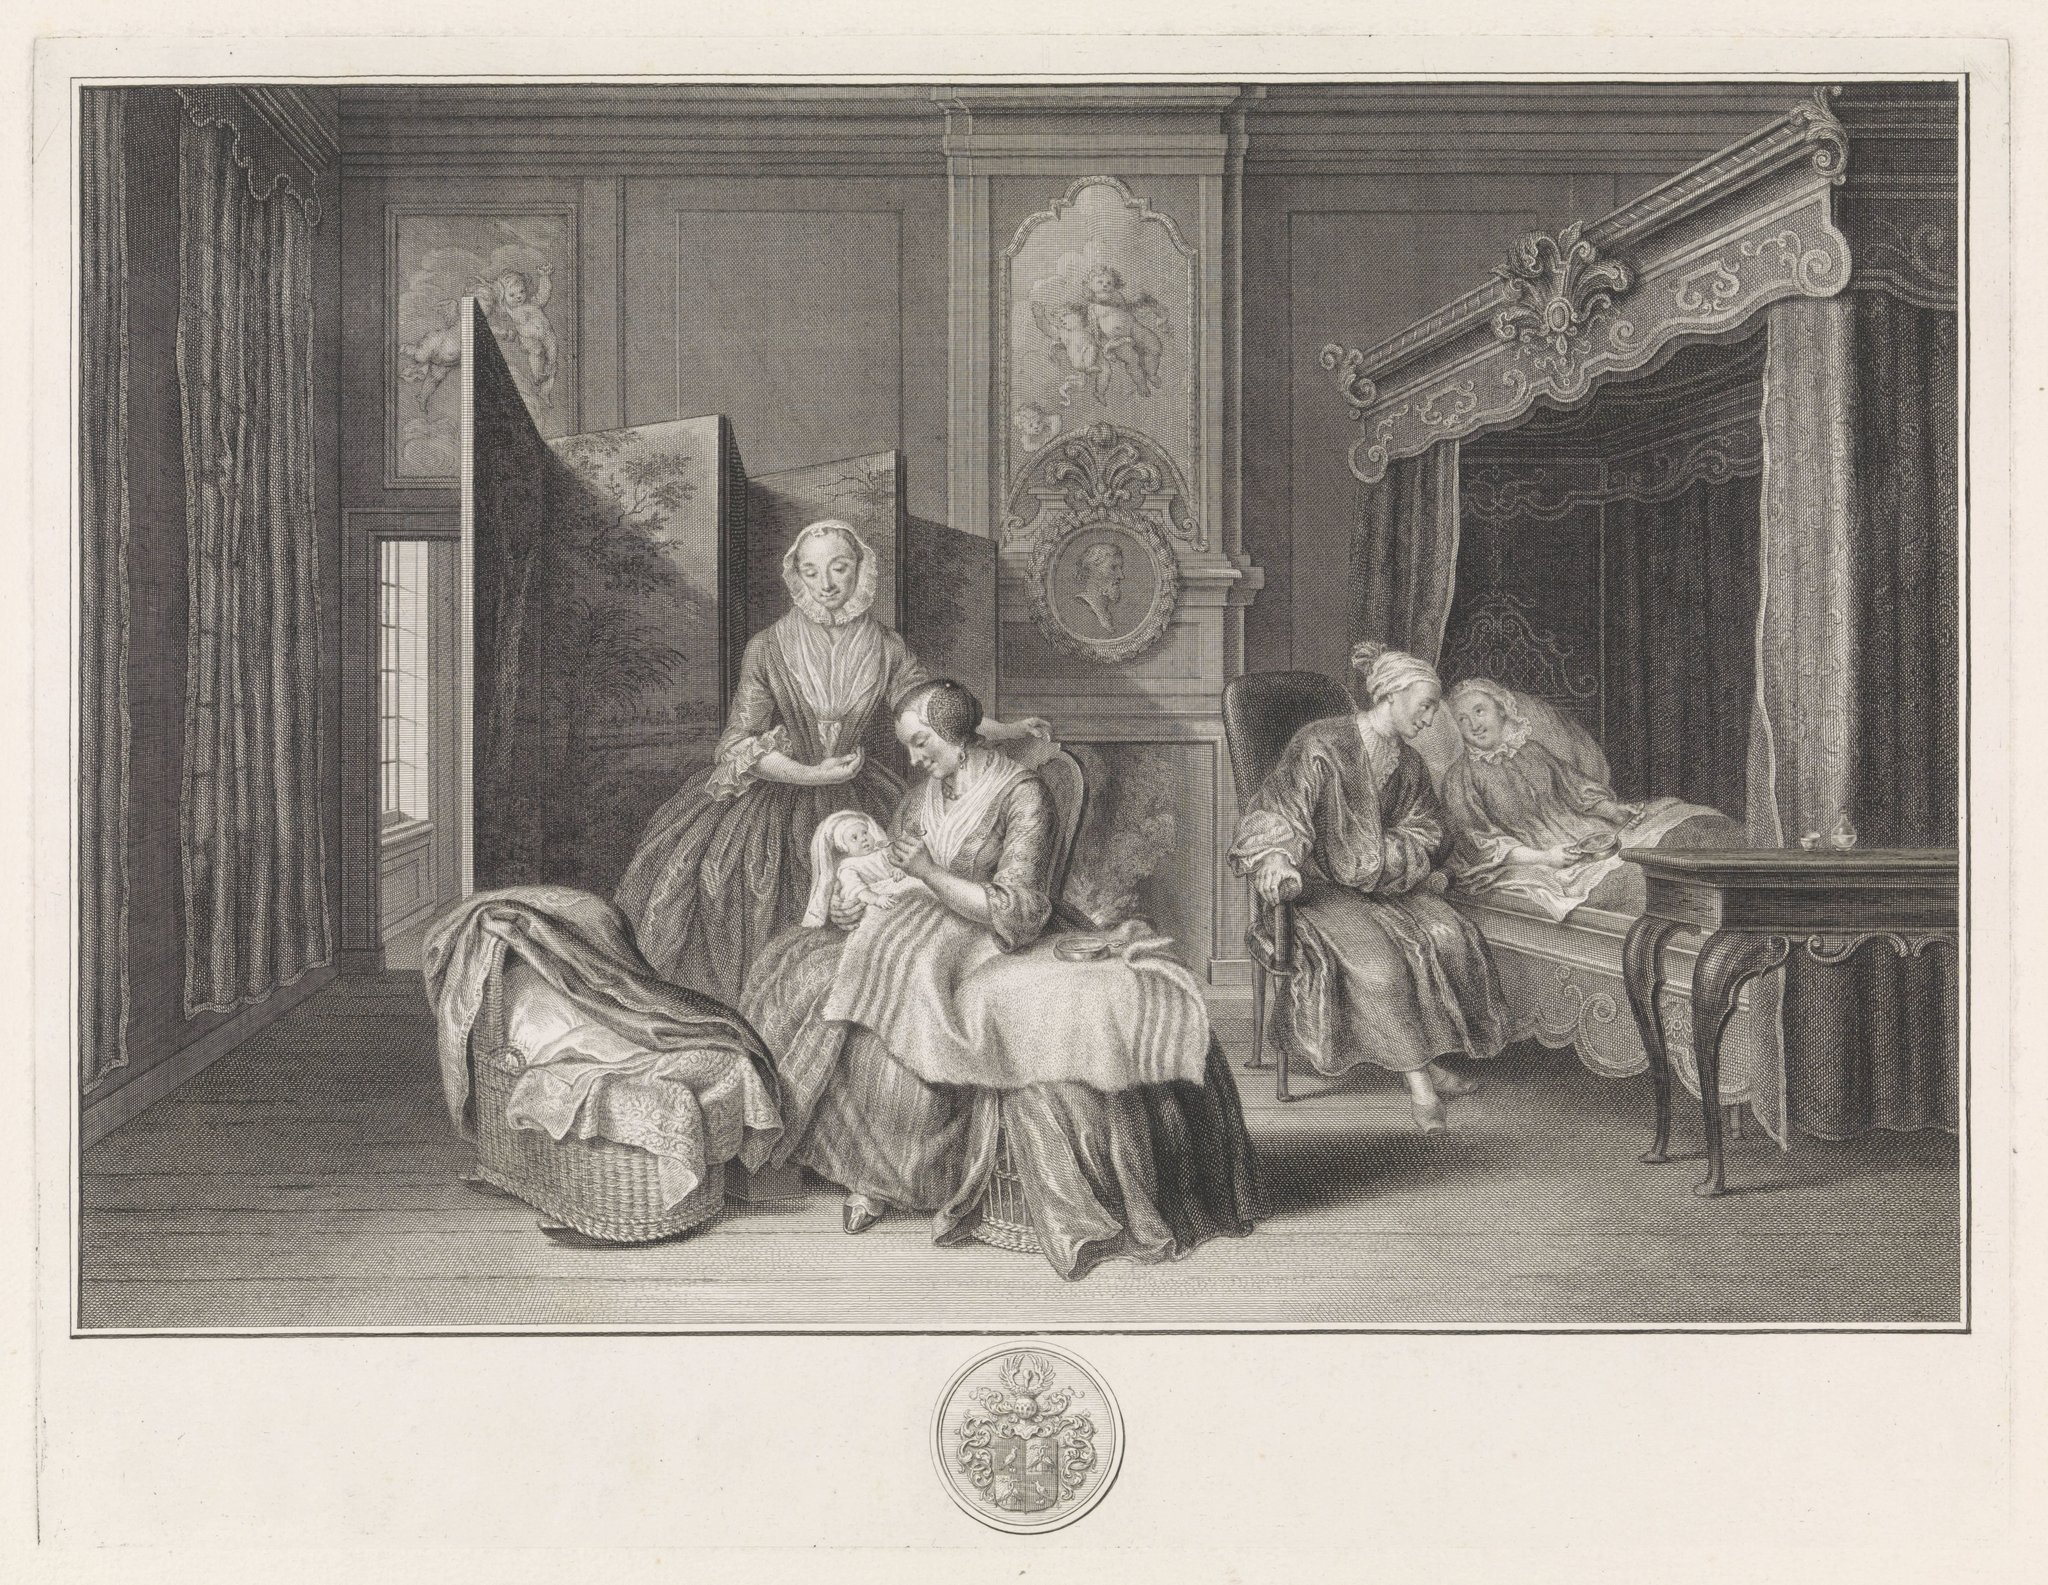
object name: print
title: Hollandse kraamkamer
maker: pieter tanjé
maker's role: draughtsman, print maker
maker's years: 1706-1761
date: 1757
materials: paper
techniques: engraving, etching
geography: amsterdam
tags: bed with tester, cradle, crib, lying-in room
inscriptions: collector's mark: Lugt 240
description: In de kraamkamer geeft een min de baby te eten, terwijl een andere vrouw toekijkt. Rechts ligt de moeder in een hemelbed. Naast haar zit haar man. Onderaan in de marge het wapenschild van Johann Goll van Frankenstein, die het originele schilderij in bezit had.